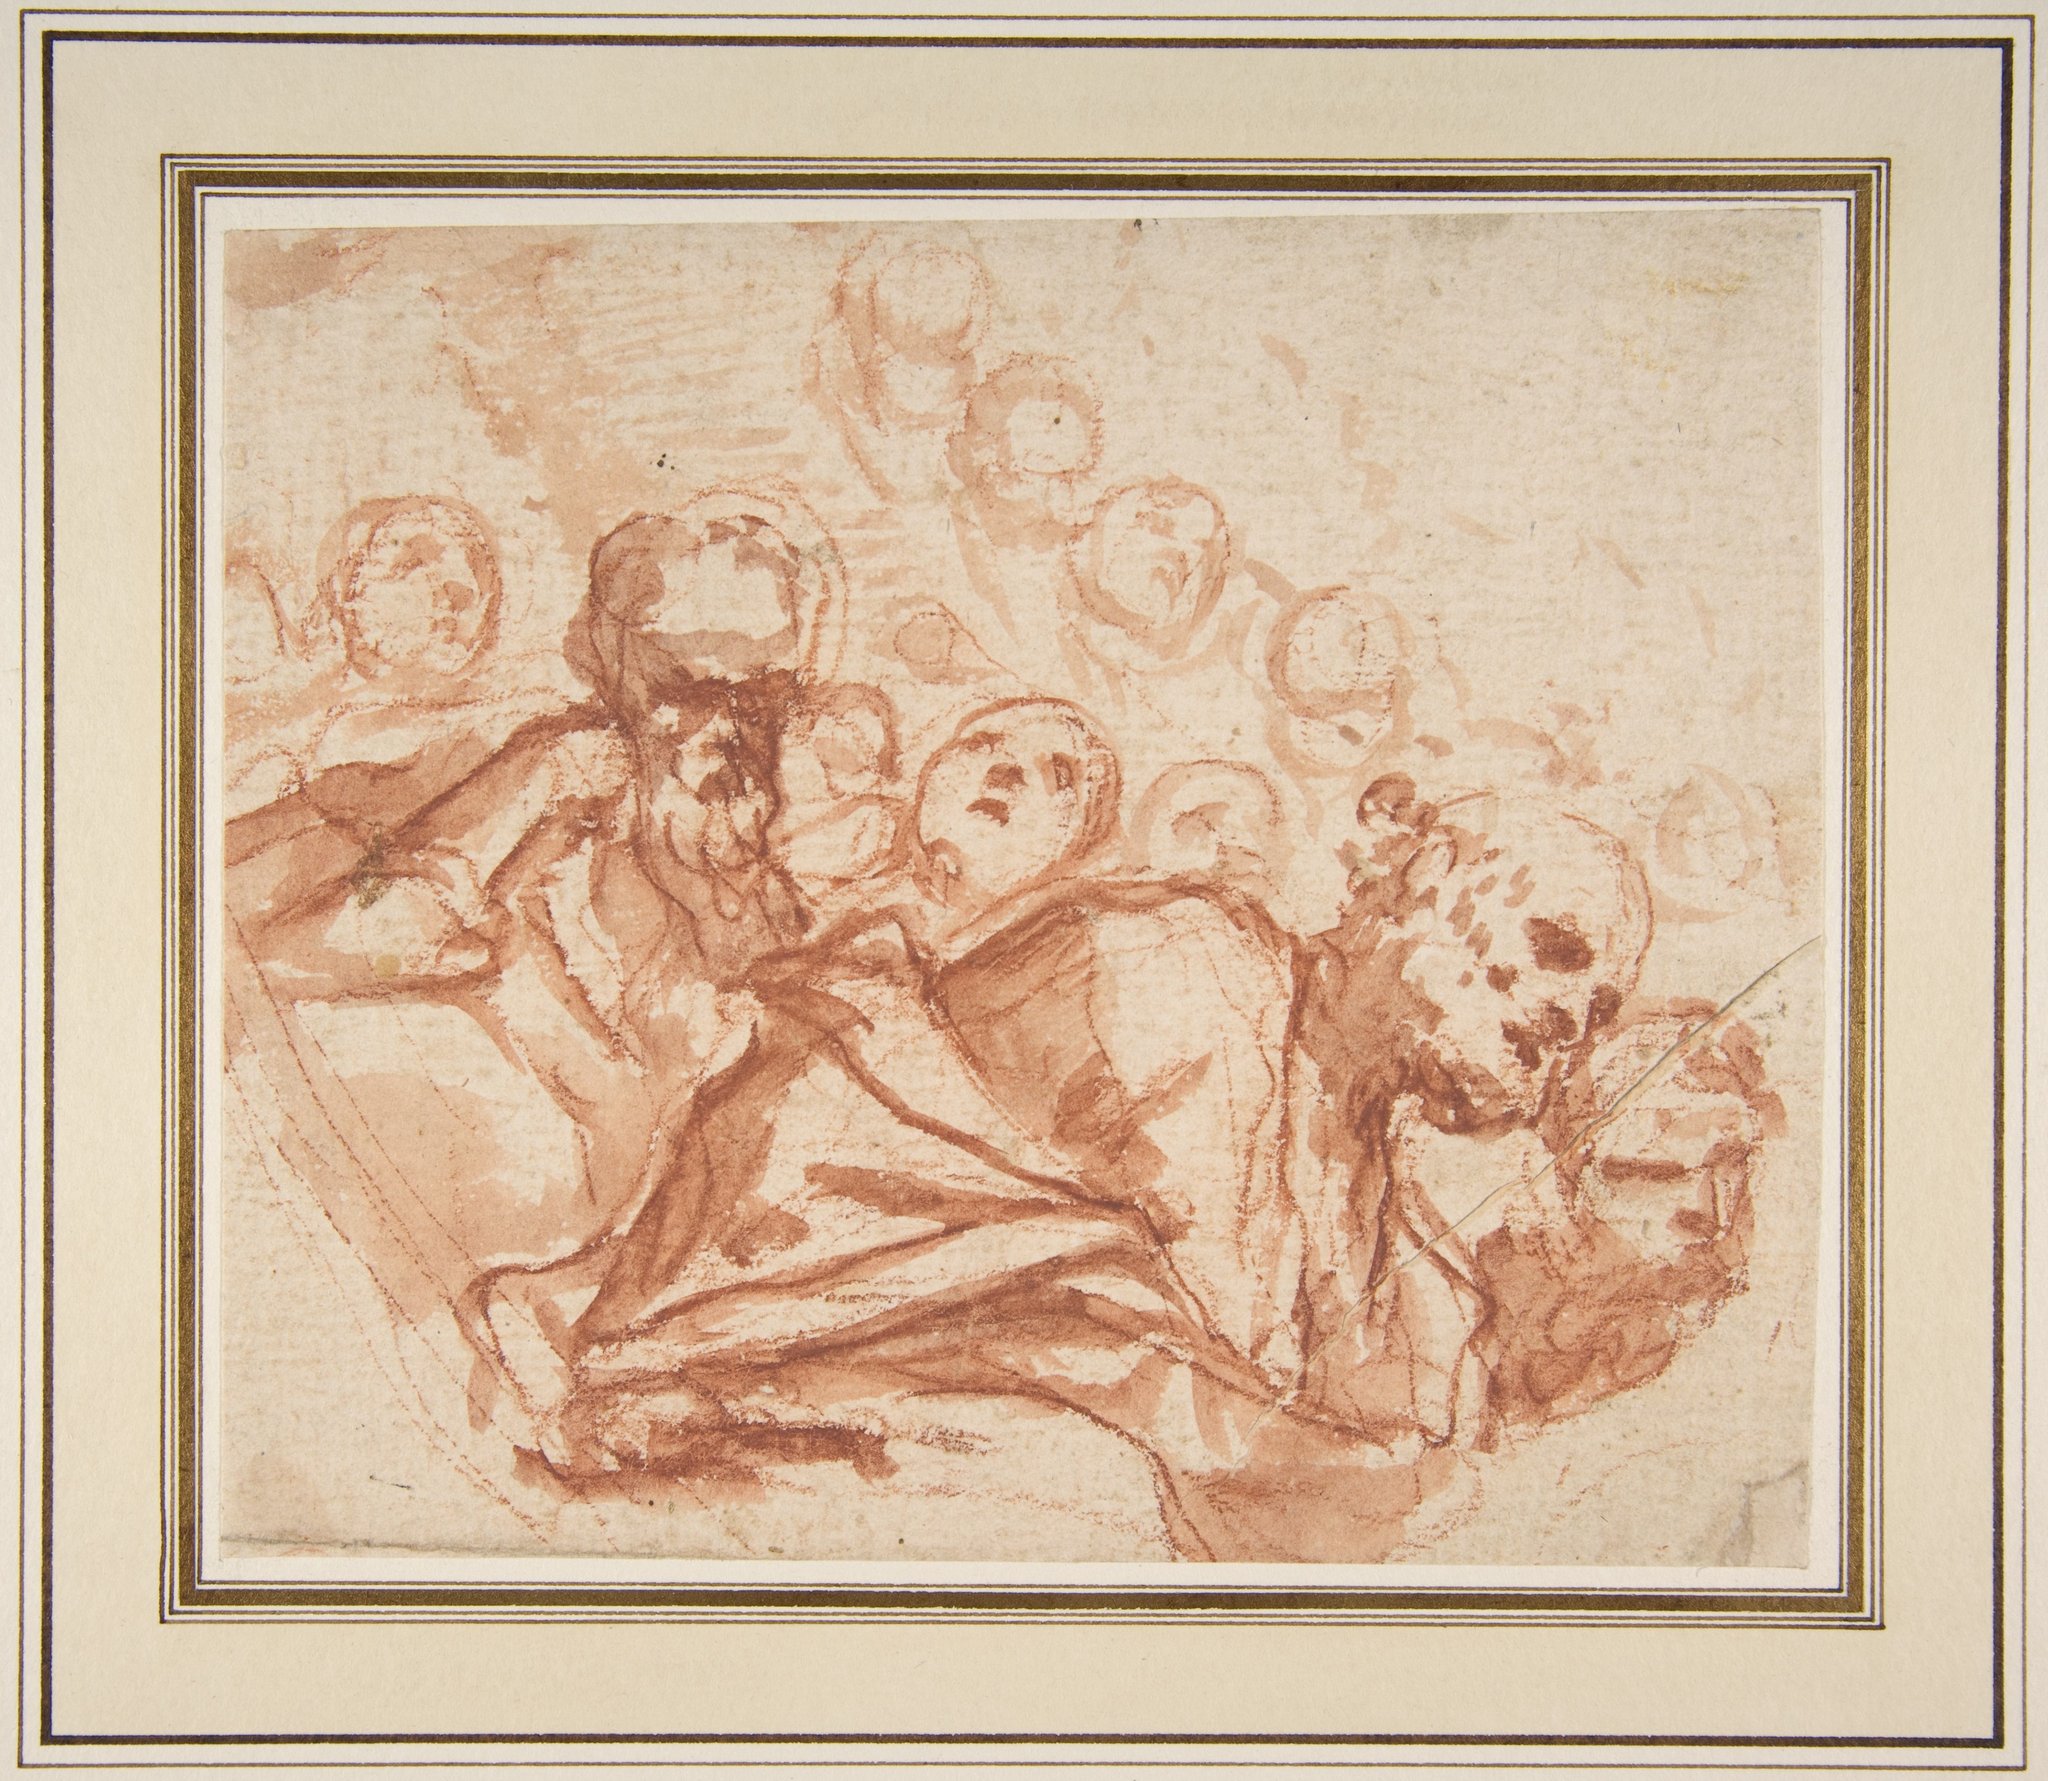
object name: drawing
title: A Group of Saints and Angels (recto); Studies of a Male Figure in a Pendentive (verso)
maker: mattia preti (il cavalier calabrese)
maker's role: artist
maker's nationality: italian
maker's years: 1613-1699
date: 1613-1699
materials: chalk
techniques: brush, wash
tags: angels,saints